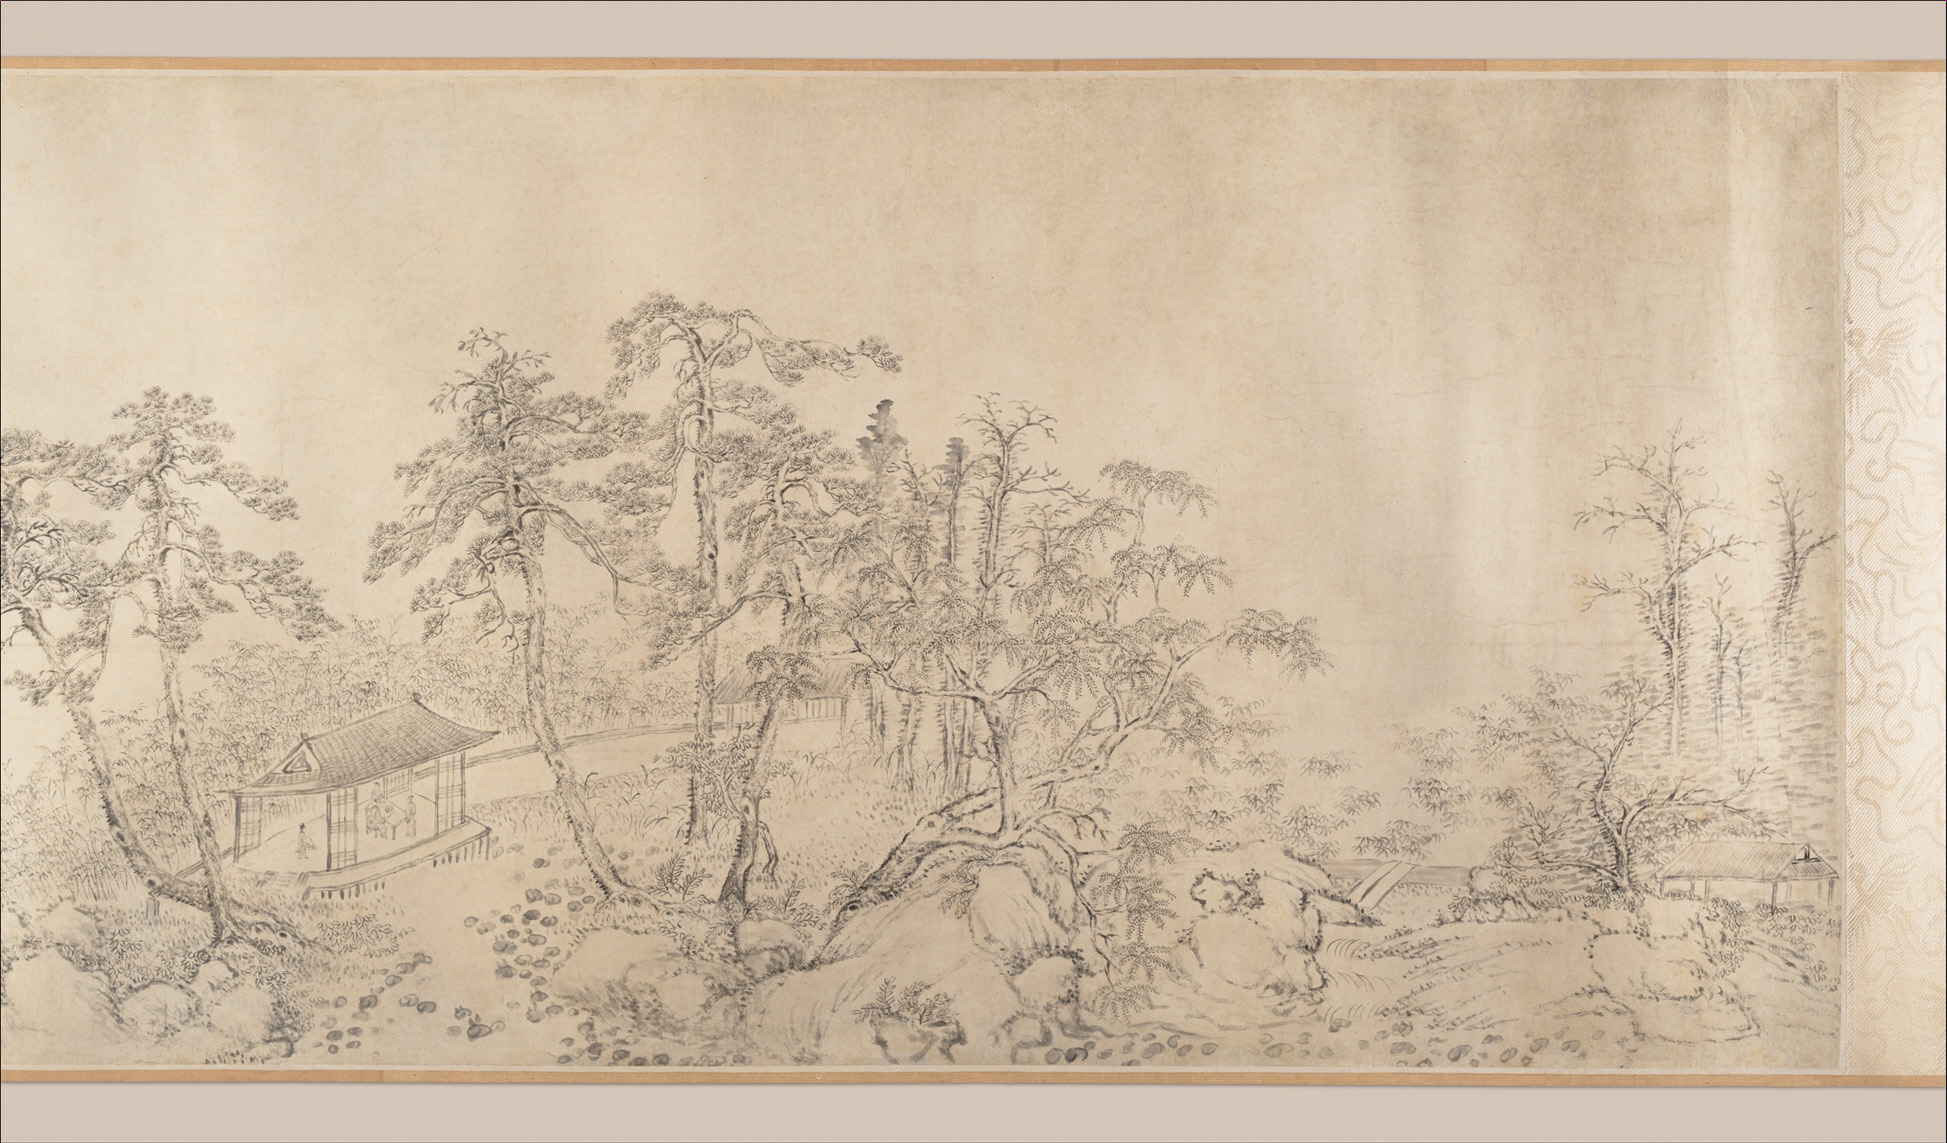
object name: handscroll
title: Discourse on Poetry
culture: chinese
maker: gao jian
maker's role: artist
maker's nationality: chinese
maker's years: 1634-1725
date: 1698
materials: ink, paper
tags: gardens,landscapes